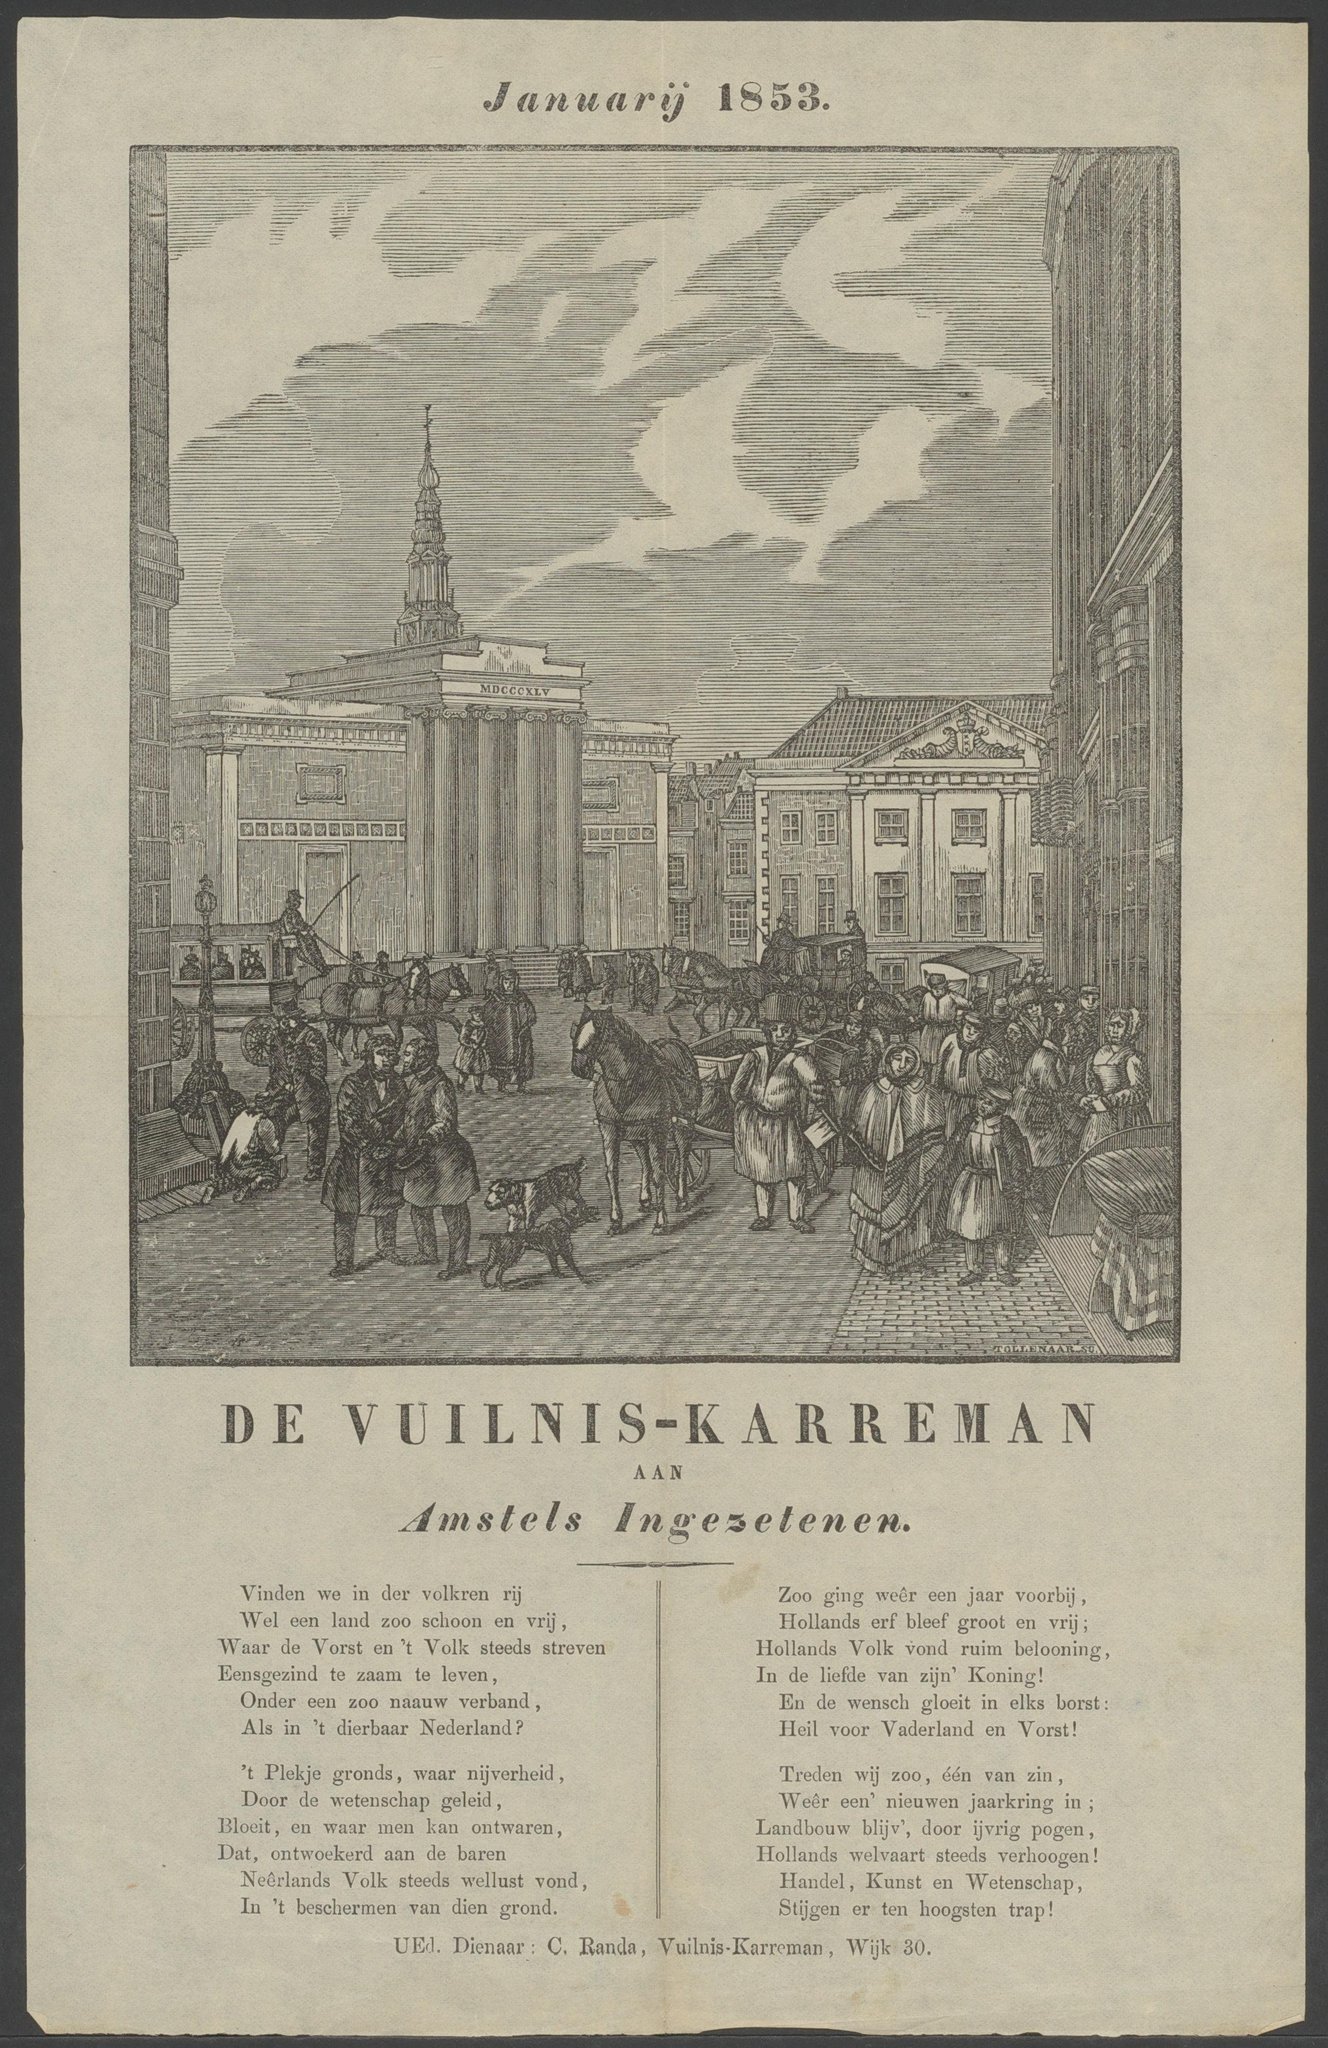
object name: print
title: Nieuwjaarswens van de vuilnismannen van Amsterdam voor het jaar 1853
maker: dirk wijbrand tollenaar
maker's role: print maker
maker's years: 1808-1858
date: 1852-1853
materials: paper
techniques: letterpress printing, engraving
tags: street, garbage collection, amsterdam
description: Nieuwjaarswens van de Amsterdamse vuilnismannen voor het jaar 1851. Gezicht op de Dam met de Beurs van Zocher en het Commandantshuis te Amsterdam. Tussen het publiek de vuilnismannen met hun kar. Met gedicht in twee kolommen. Van de vuilniskarman in de wijk no. 30: C. Randa. Onderwerpsrubrieken binnen de Atlas Zeden en Gewoonten: Zeden en gewoonten in engeren zin, Volksleven, Volksbladen, Nieuwjaars- en Kerstwenschen, Amsterdam.